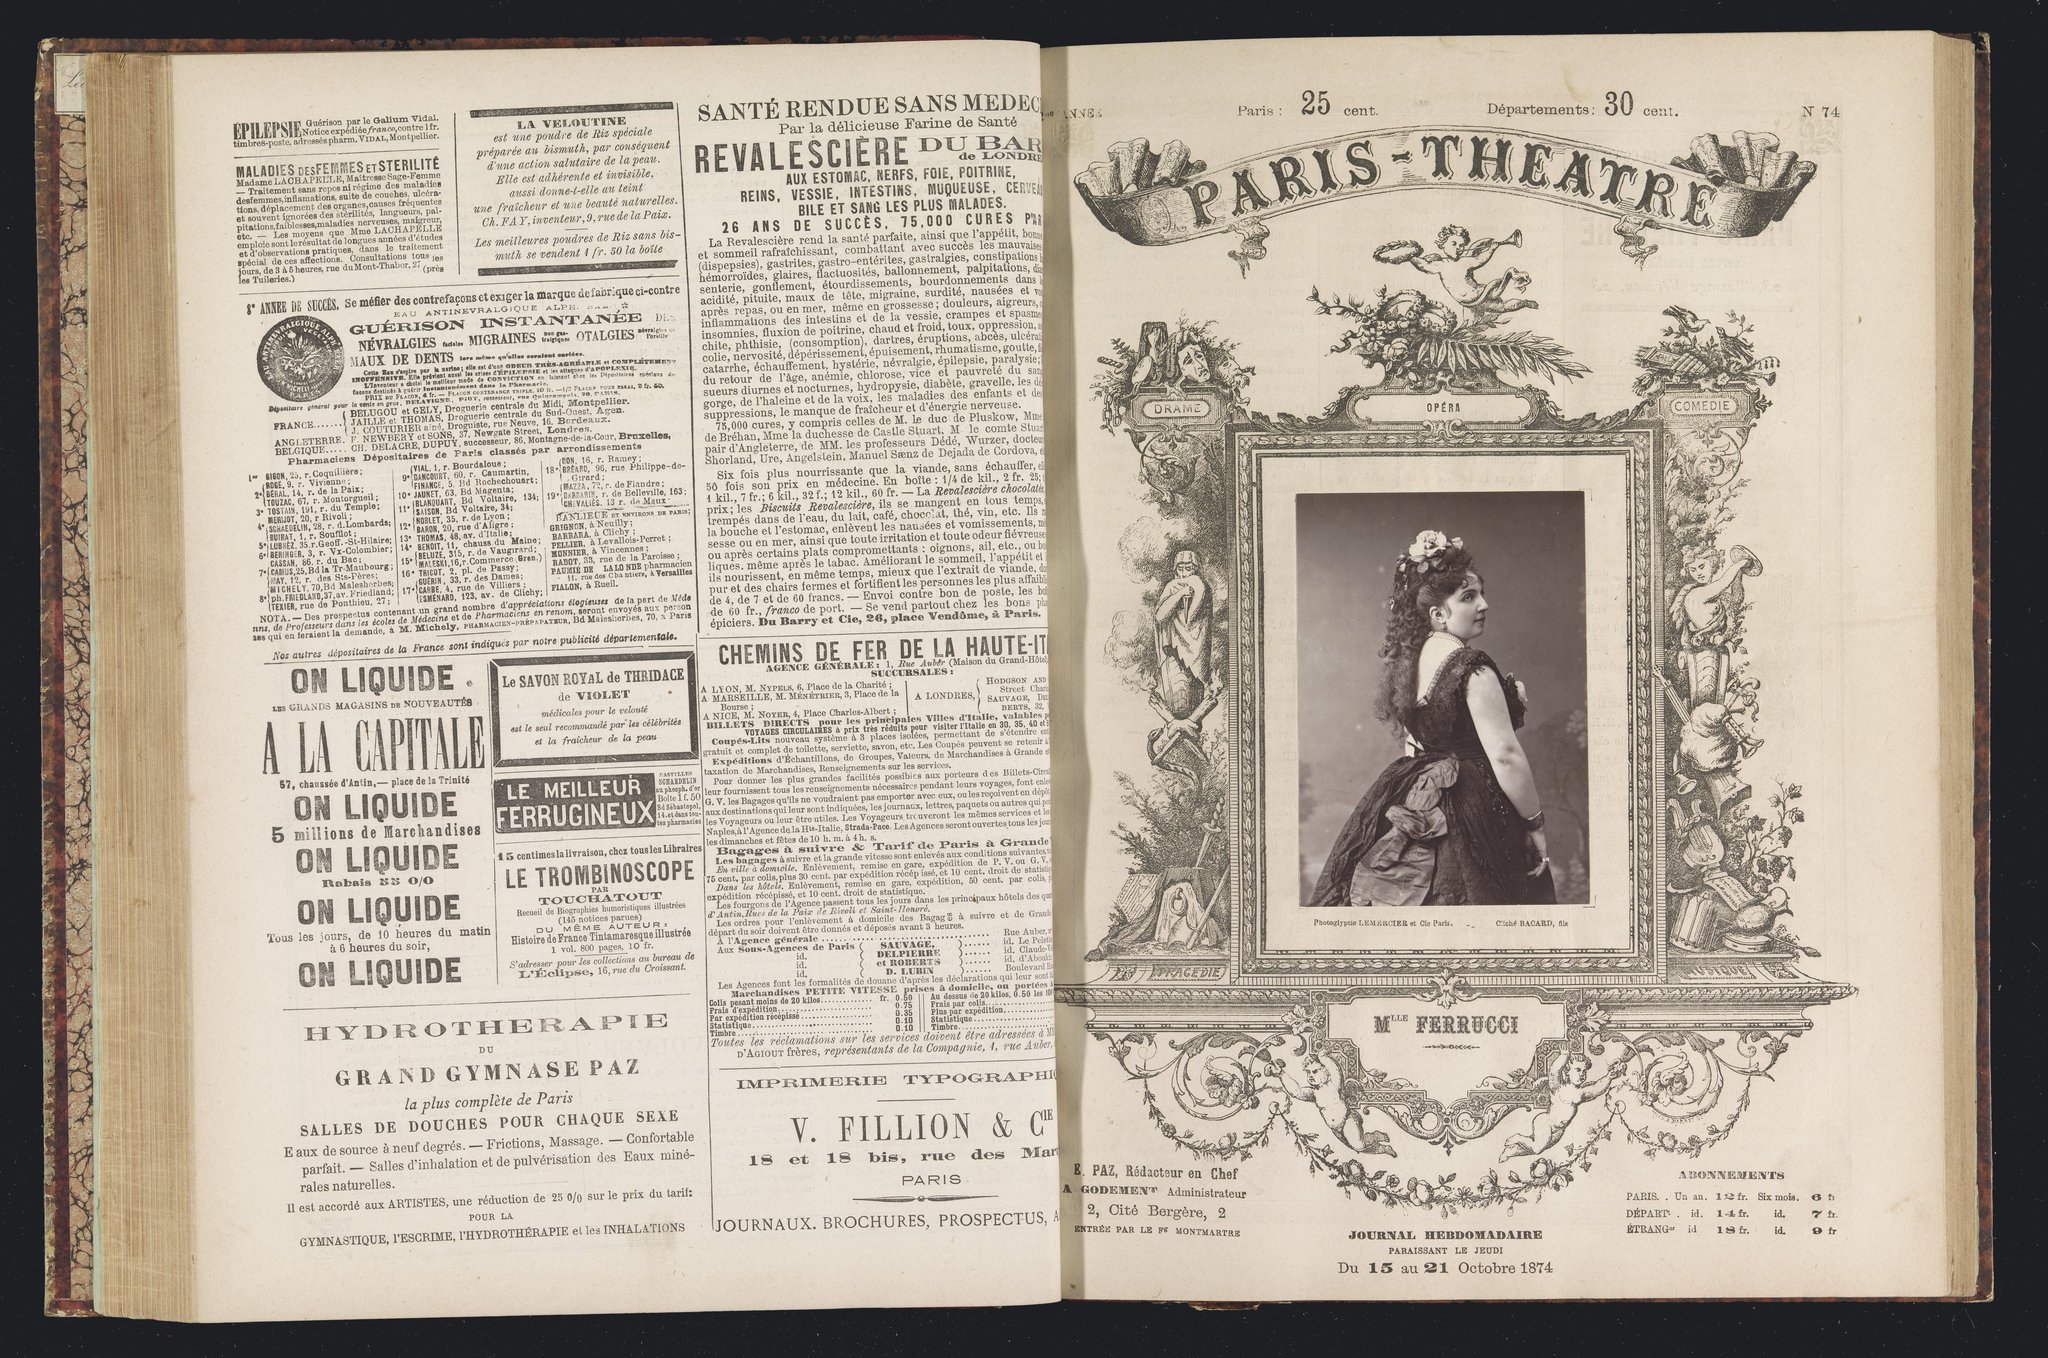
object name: photomechanical print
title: Portret van Mademoiselle Ferrucci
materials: paper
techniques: woodburytype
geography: france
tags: portrait of opera-singer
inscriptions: number: ‘No 74’, inscription: ‘Journal hebdomadaire paraissant le jeudi Du 15 au 21 Octobre 1874’